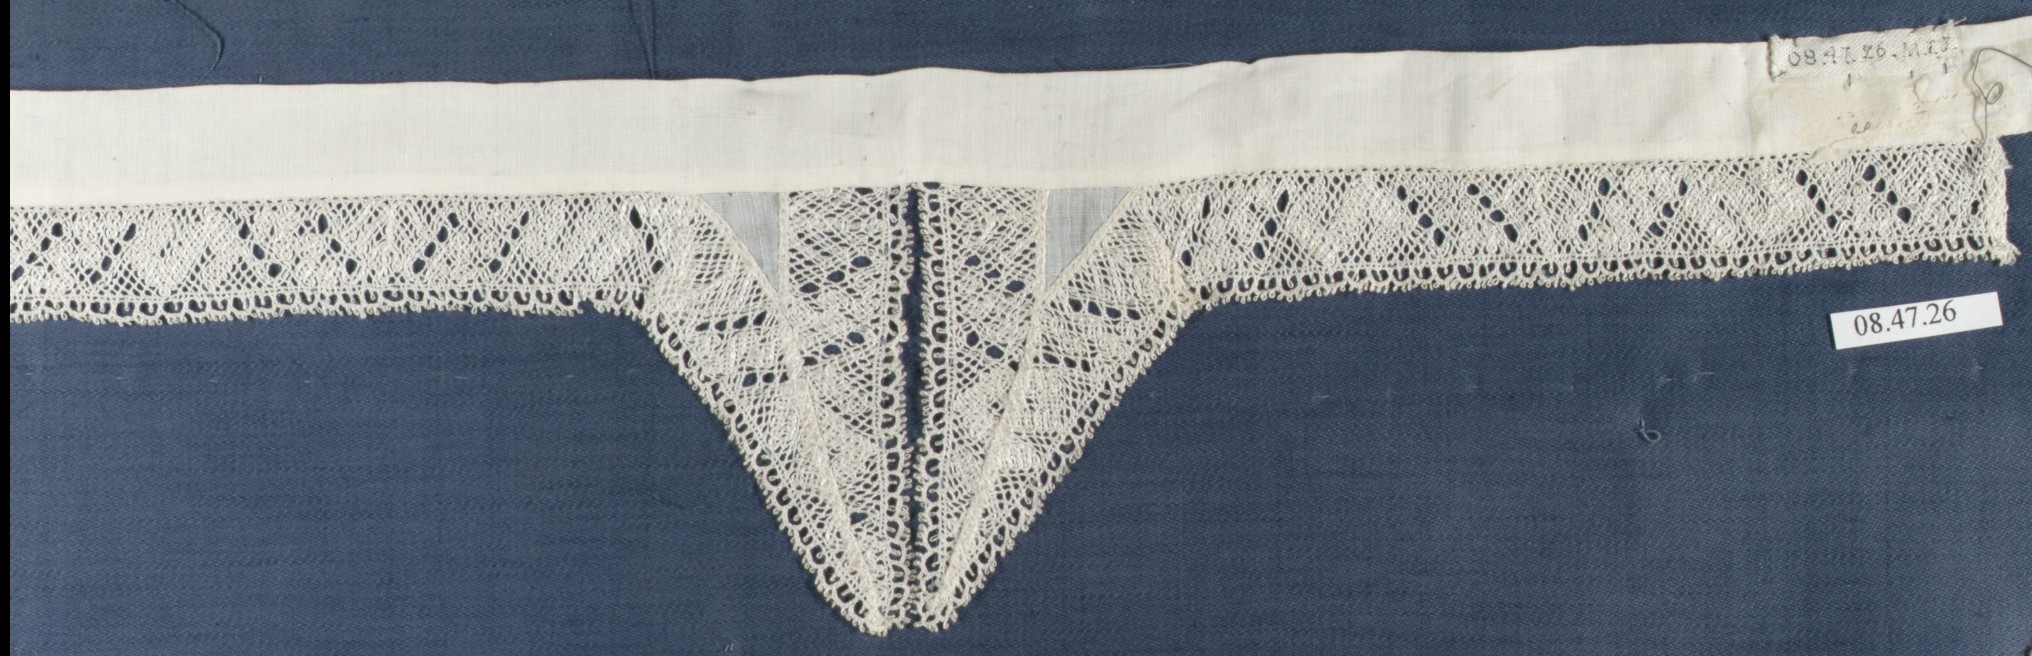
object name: collar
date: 1801-1900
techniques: lace